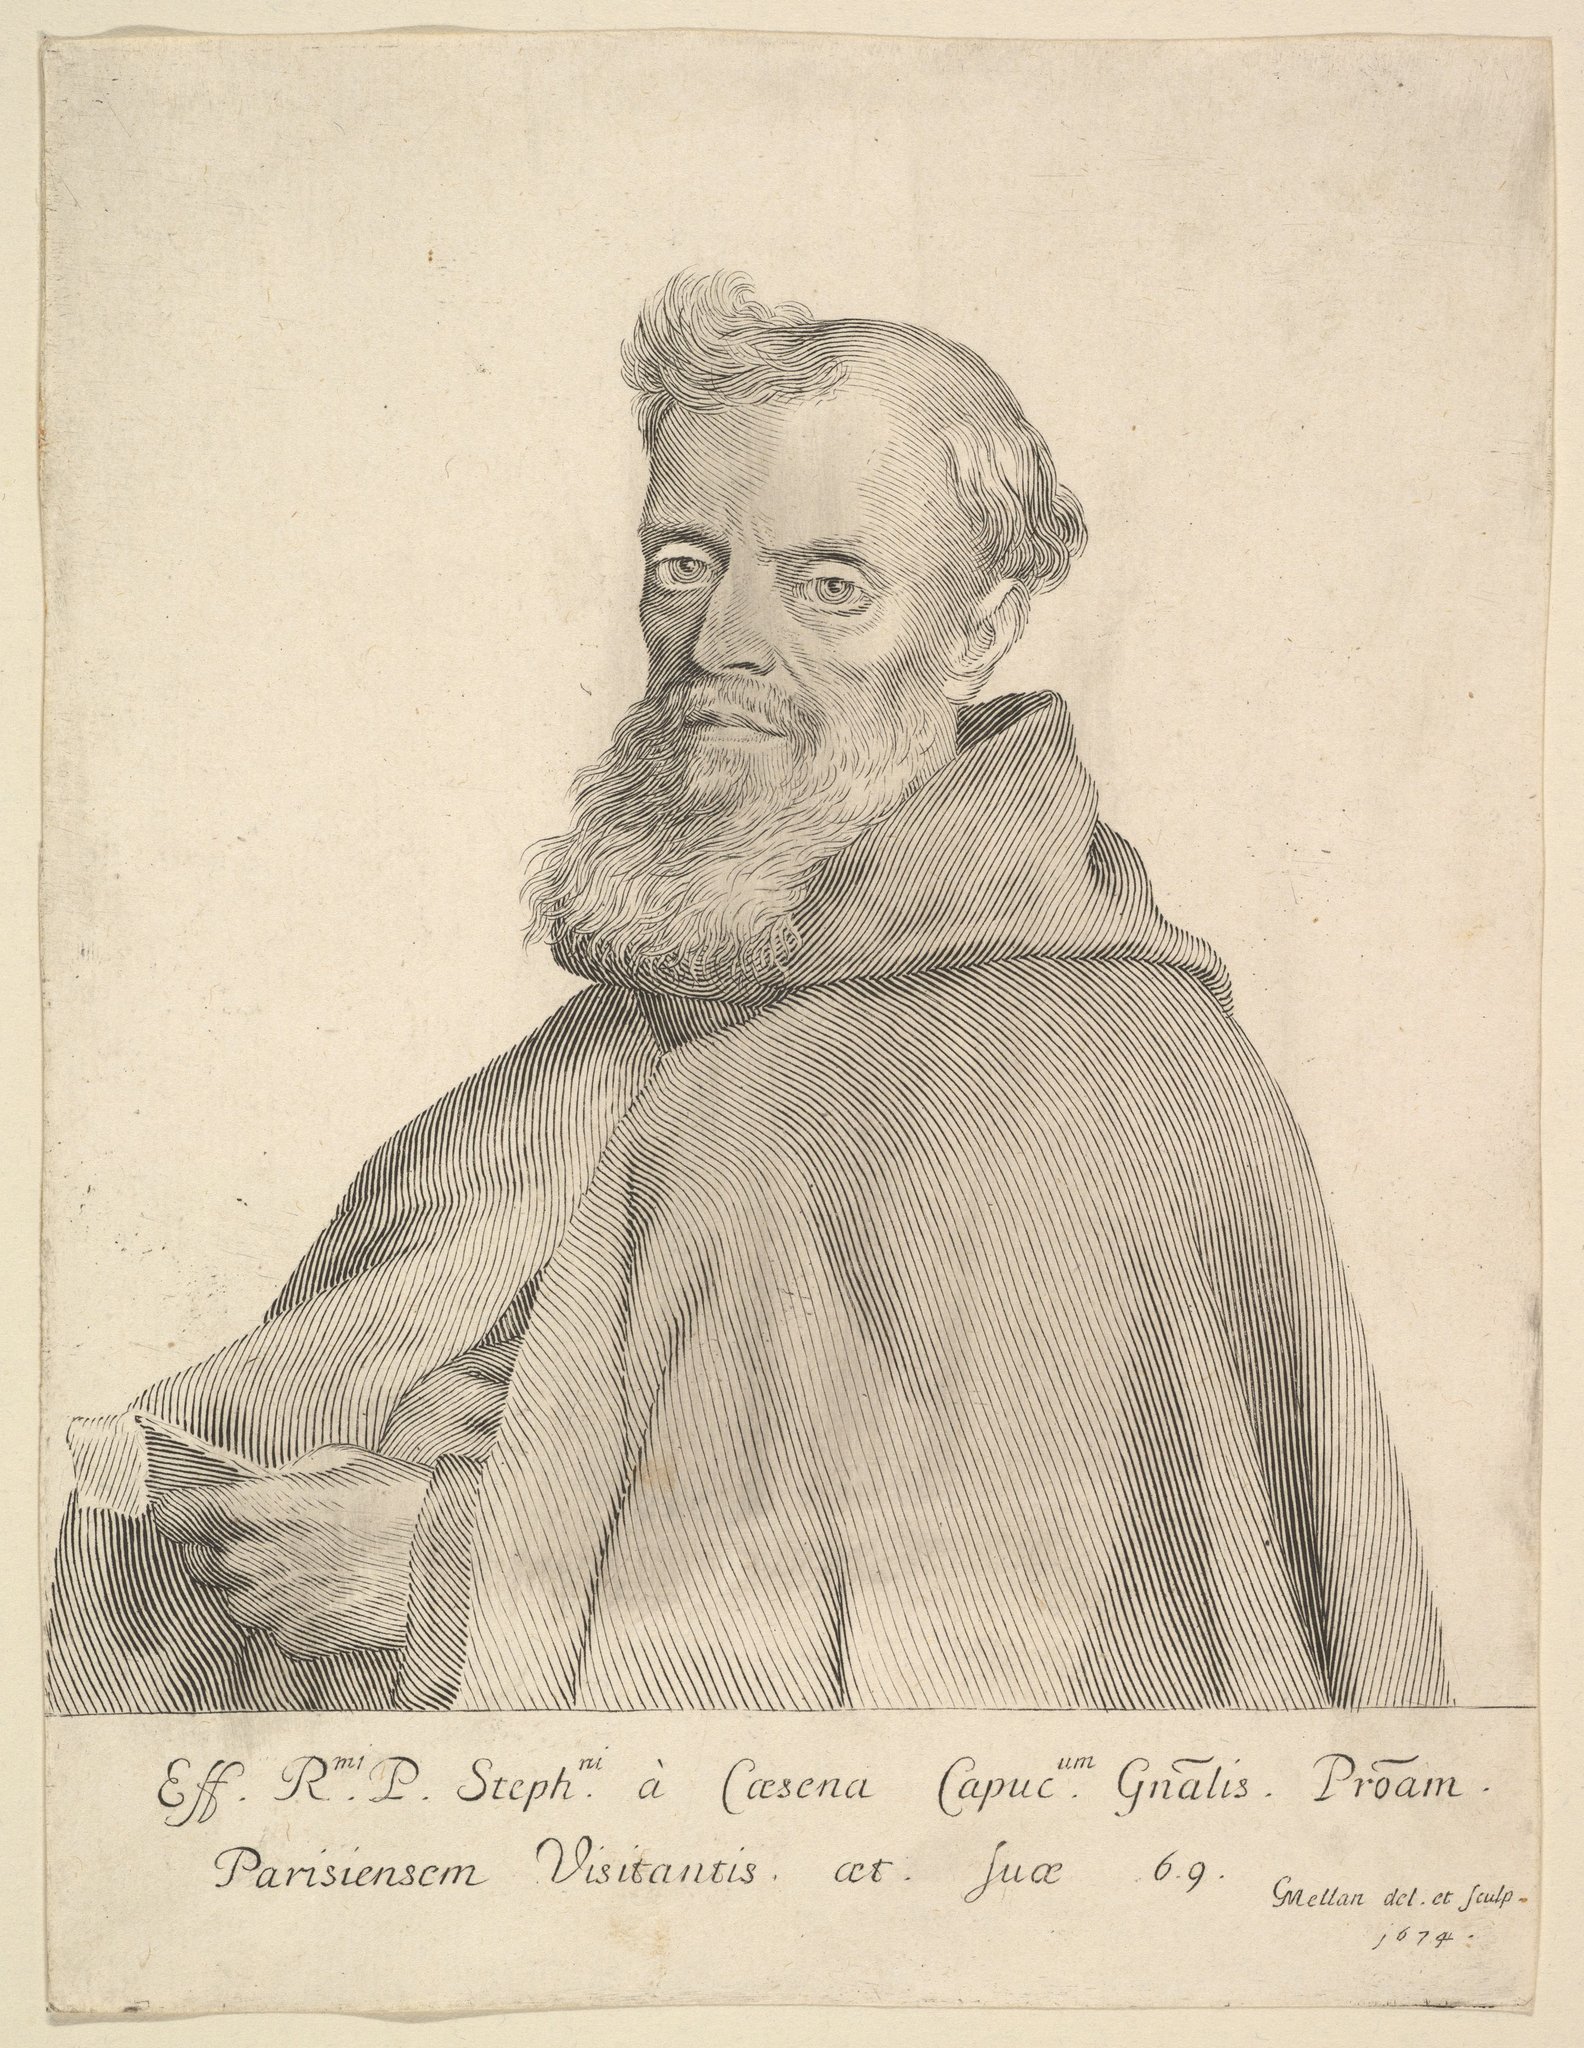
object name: print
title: Le Père Étienne de Cesena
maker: claude mellan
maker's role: artist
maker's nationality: french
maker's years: 1598-1688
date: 1674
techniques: engraving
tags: men,portraits